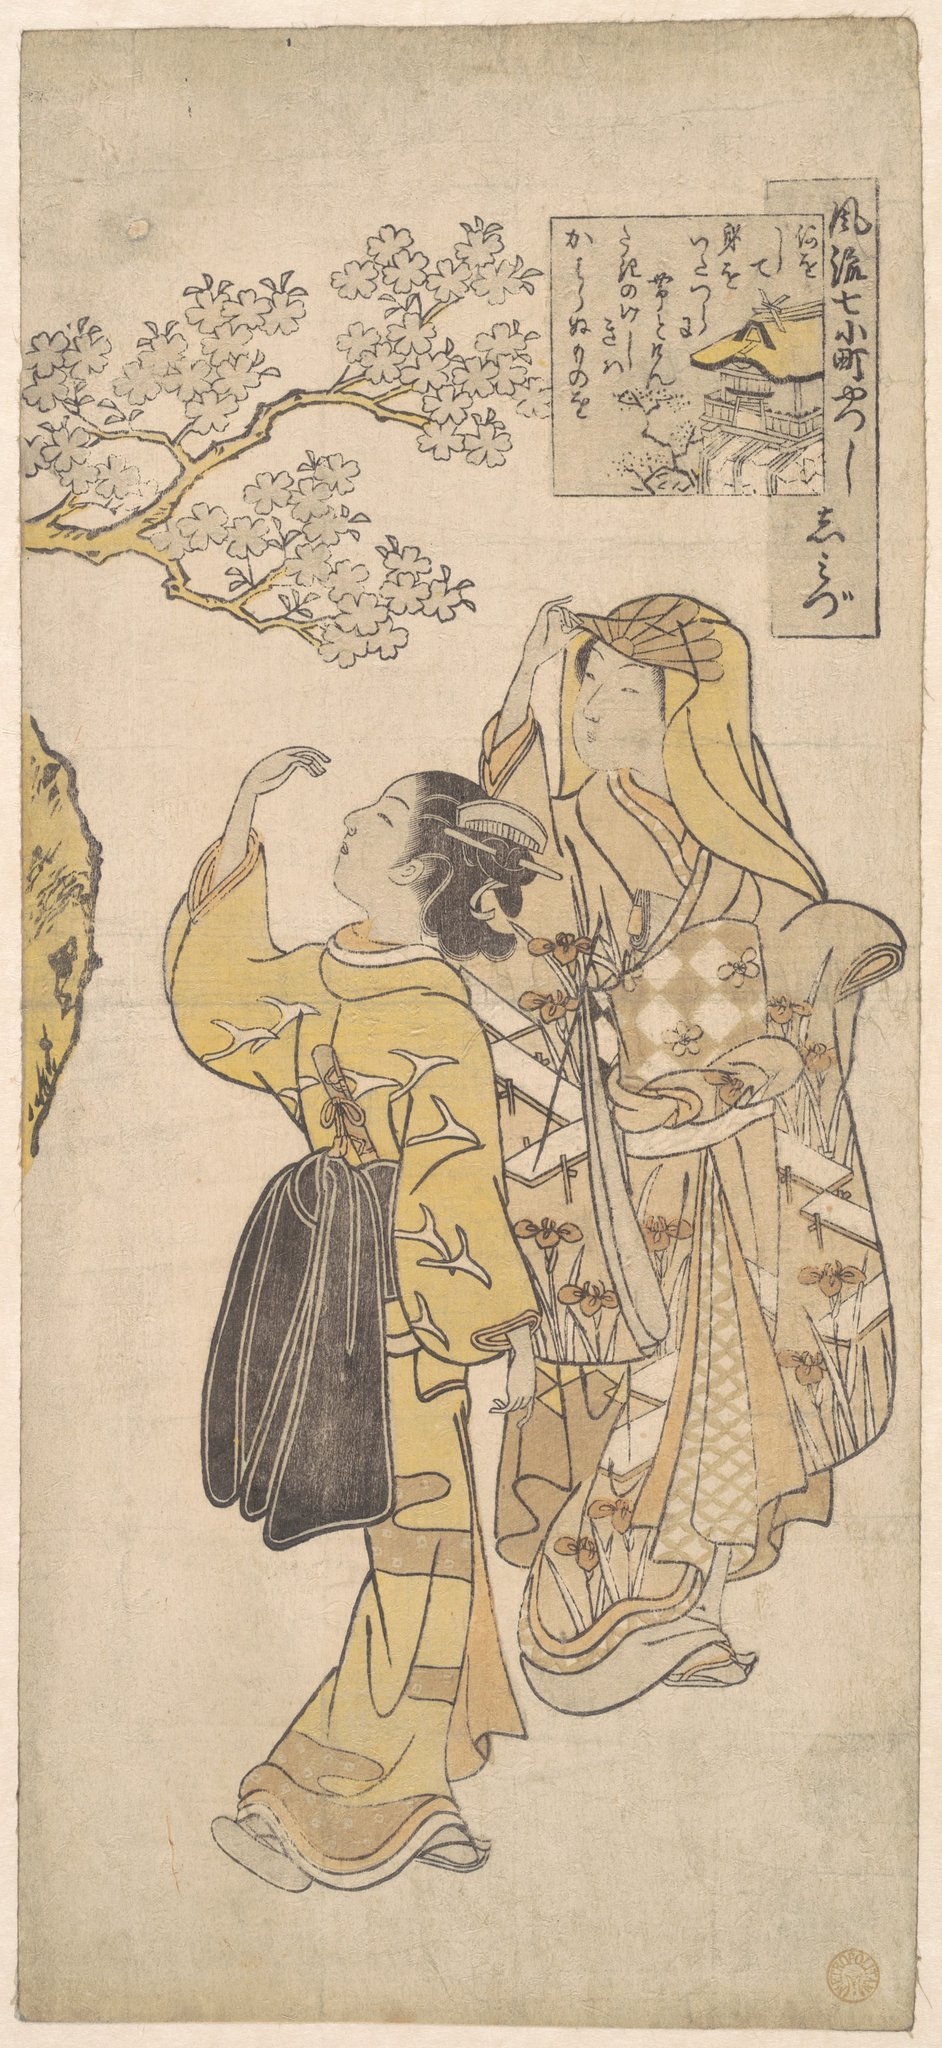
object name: print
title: Shimizu Temple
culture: japanese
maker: suzuki harunobu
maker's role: artist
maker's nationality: japanese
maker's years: 1725-1770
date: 1765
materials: ink, paper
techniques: printmaking, woodblock print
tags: women,trees